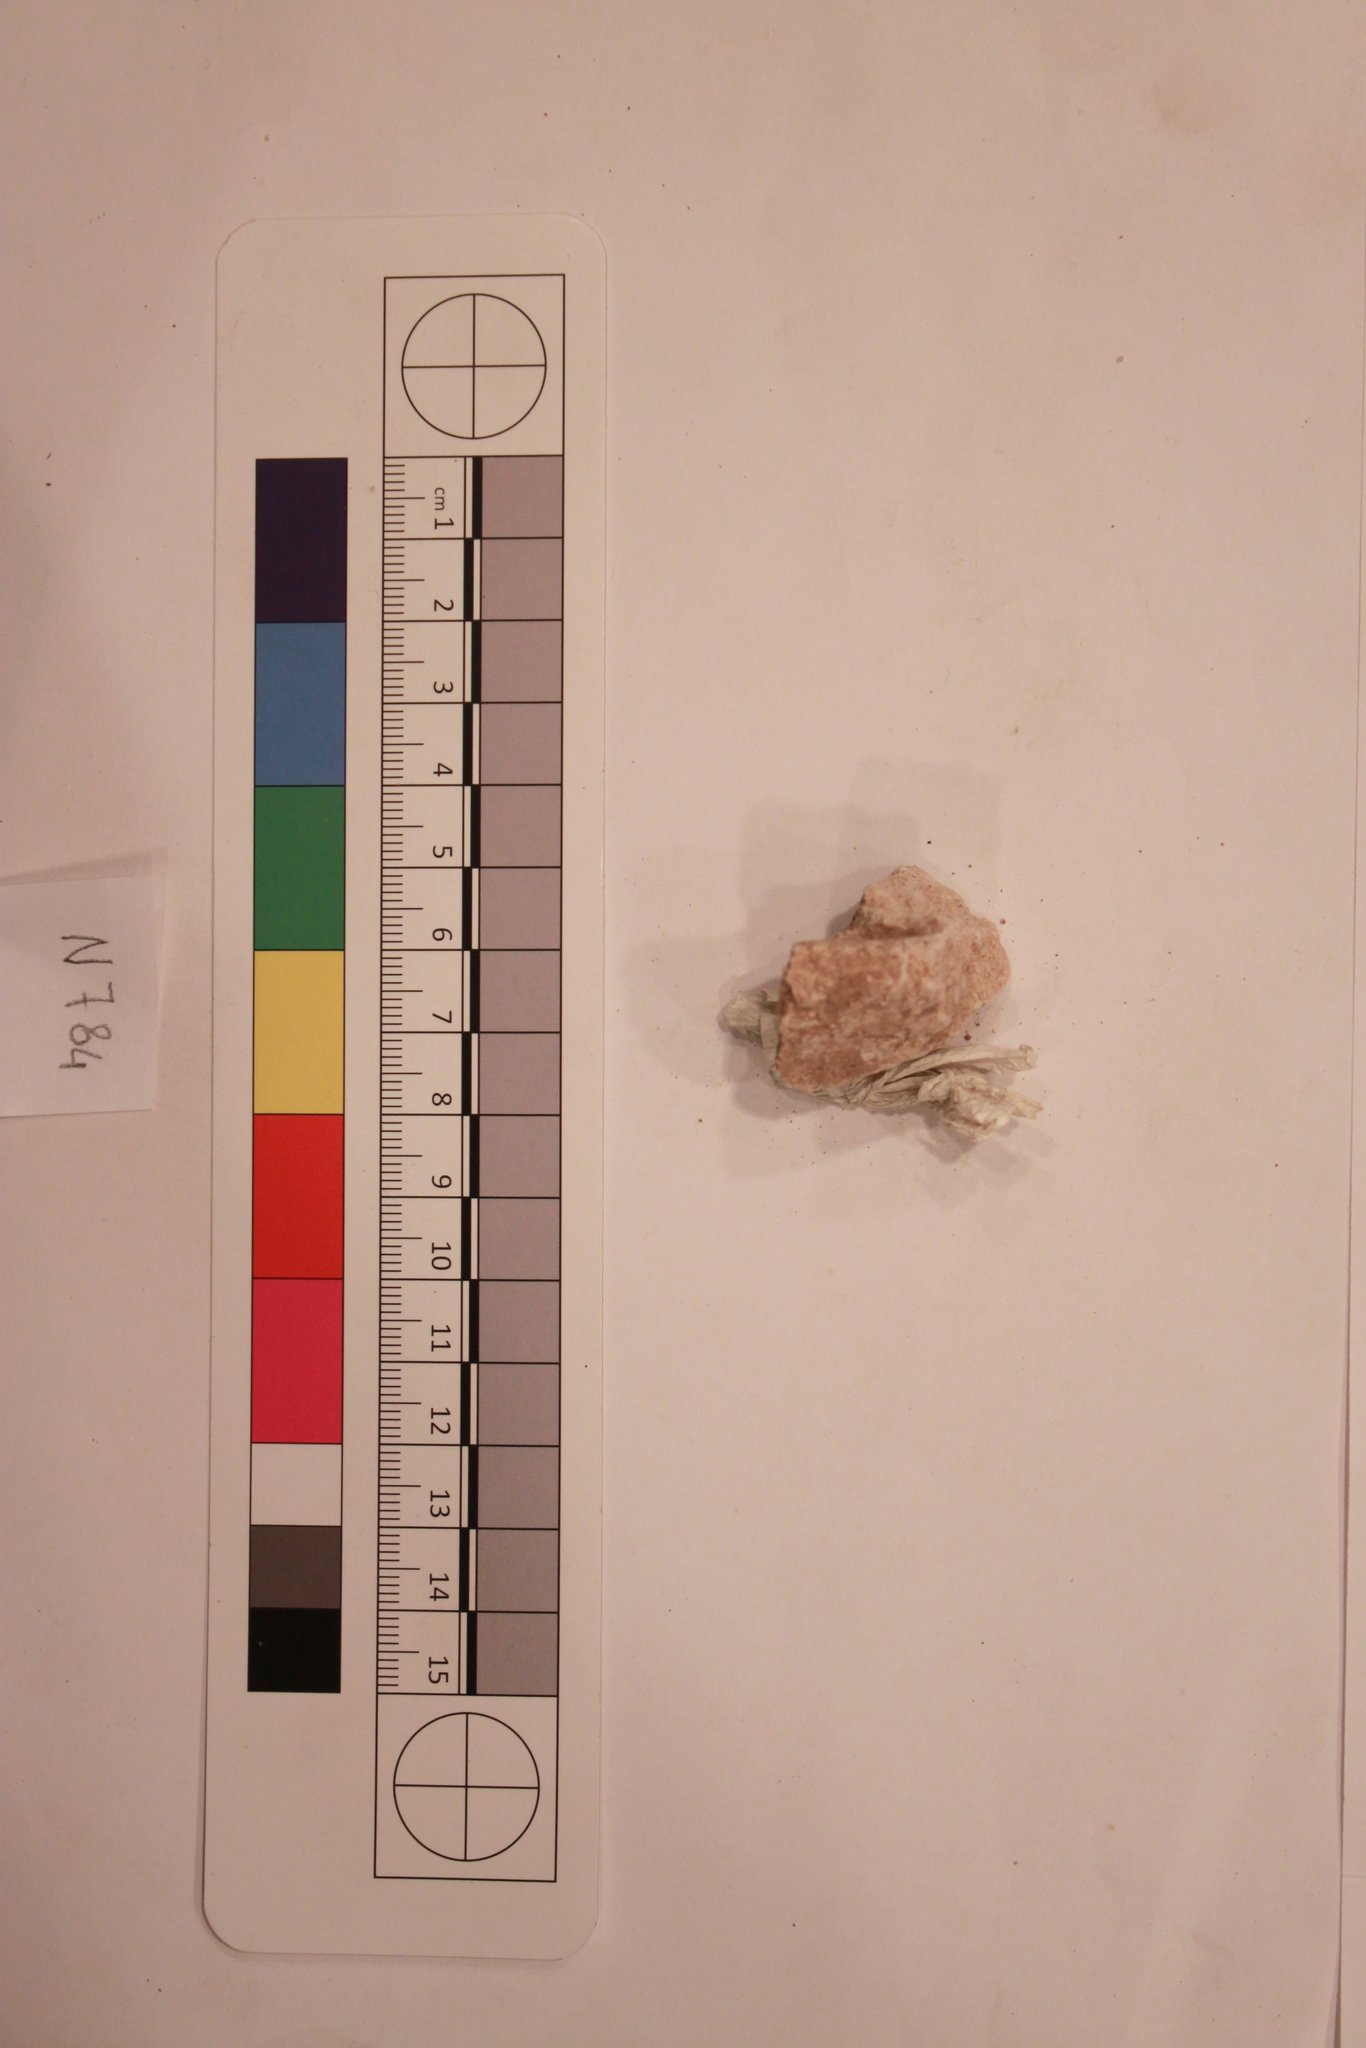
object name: fragment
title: Stucco Fragment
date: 701-1200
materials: plaster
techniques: carving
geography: iran